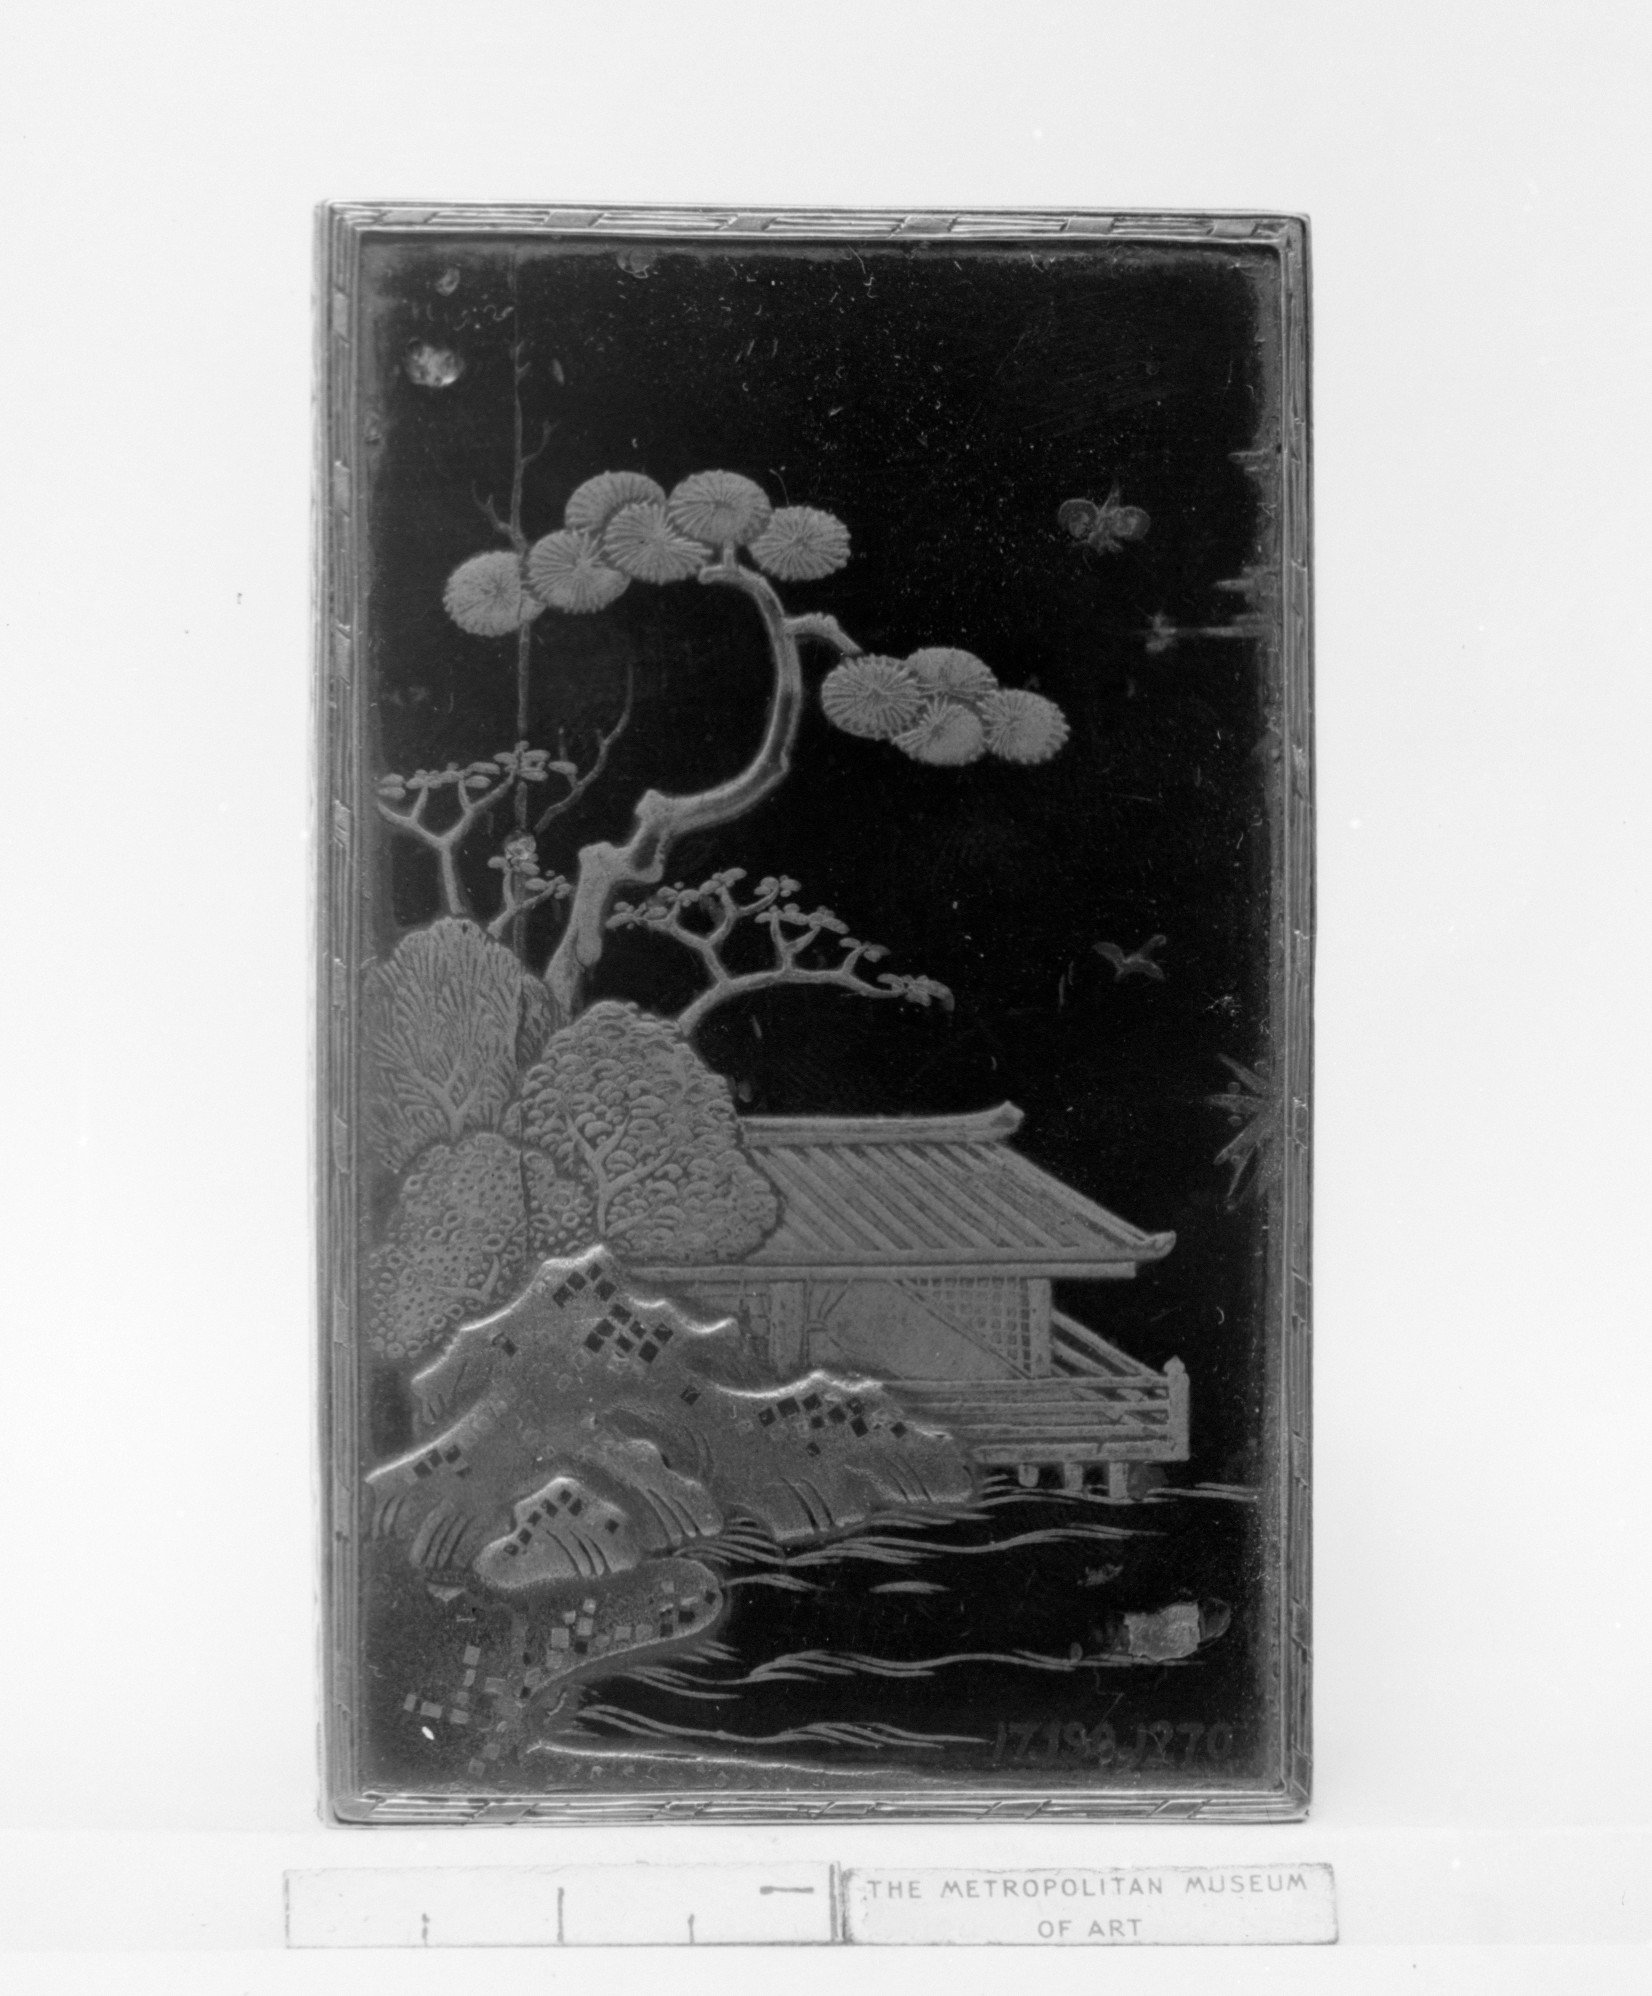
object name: souvenir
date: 1767-1833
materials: gold, ivory, lacquer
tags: houses,trees